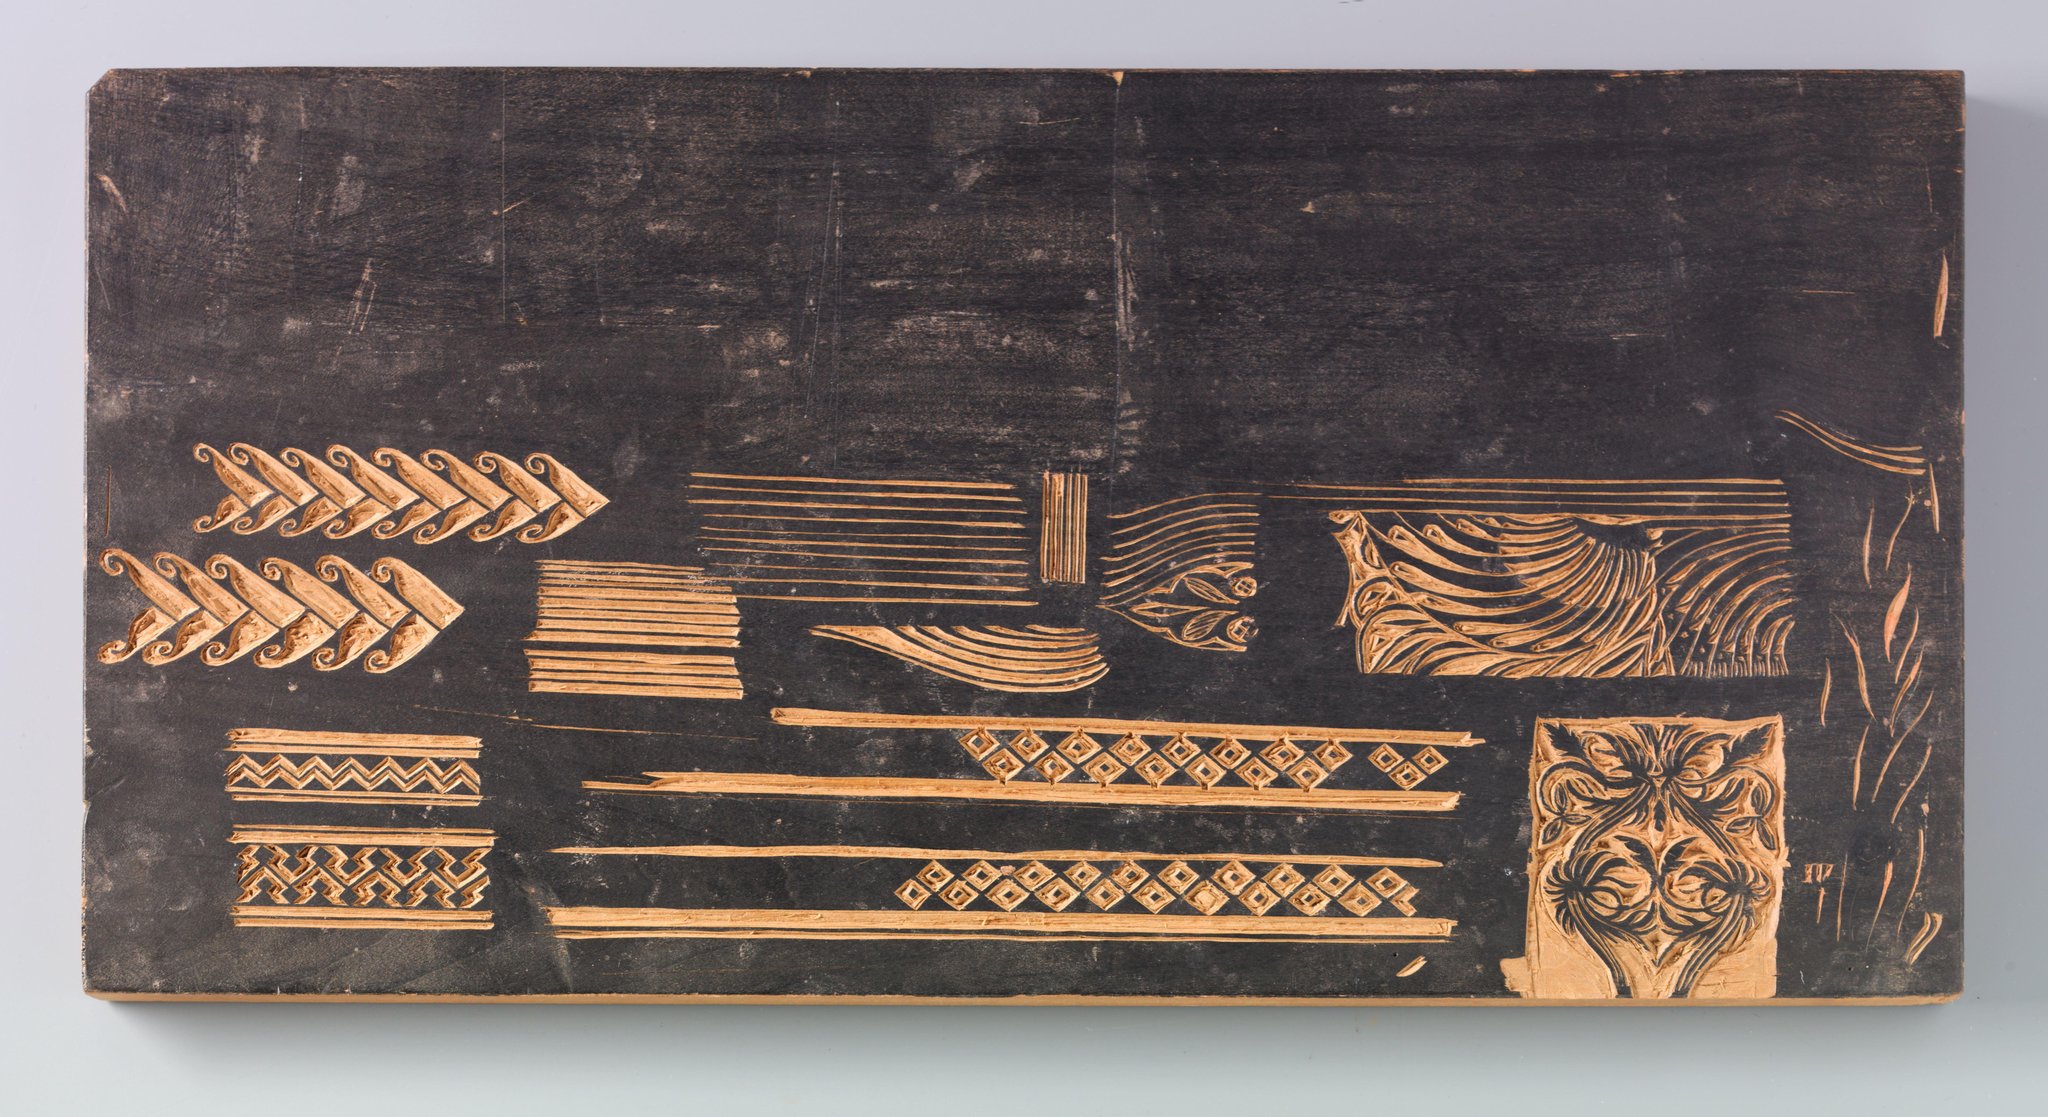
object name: wood block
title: Proefblok met decoraties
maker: gerrit willem dijsselhof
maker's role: designer, draughtsman, print maker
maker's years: 1866-1924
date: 1876-1924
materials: wood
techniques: woodcut